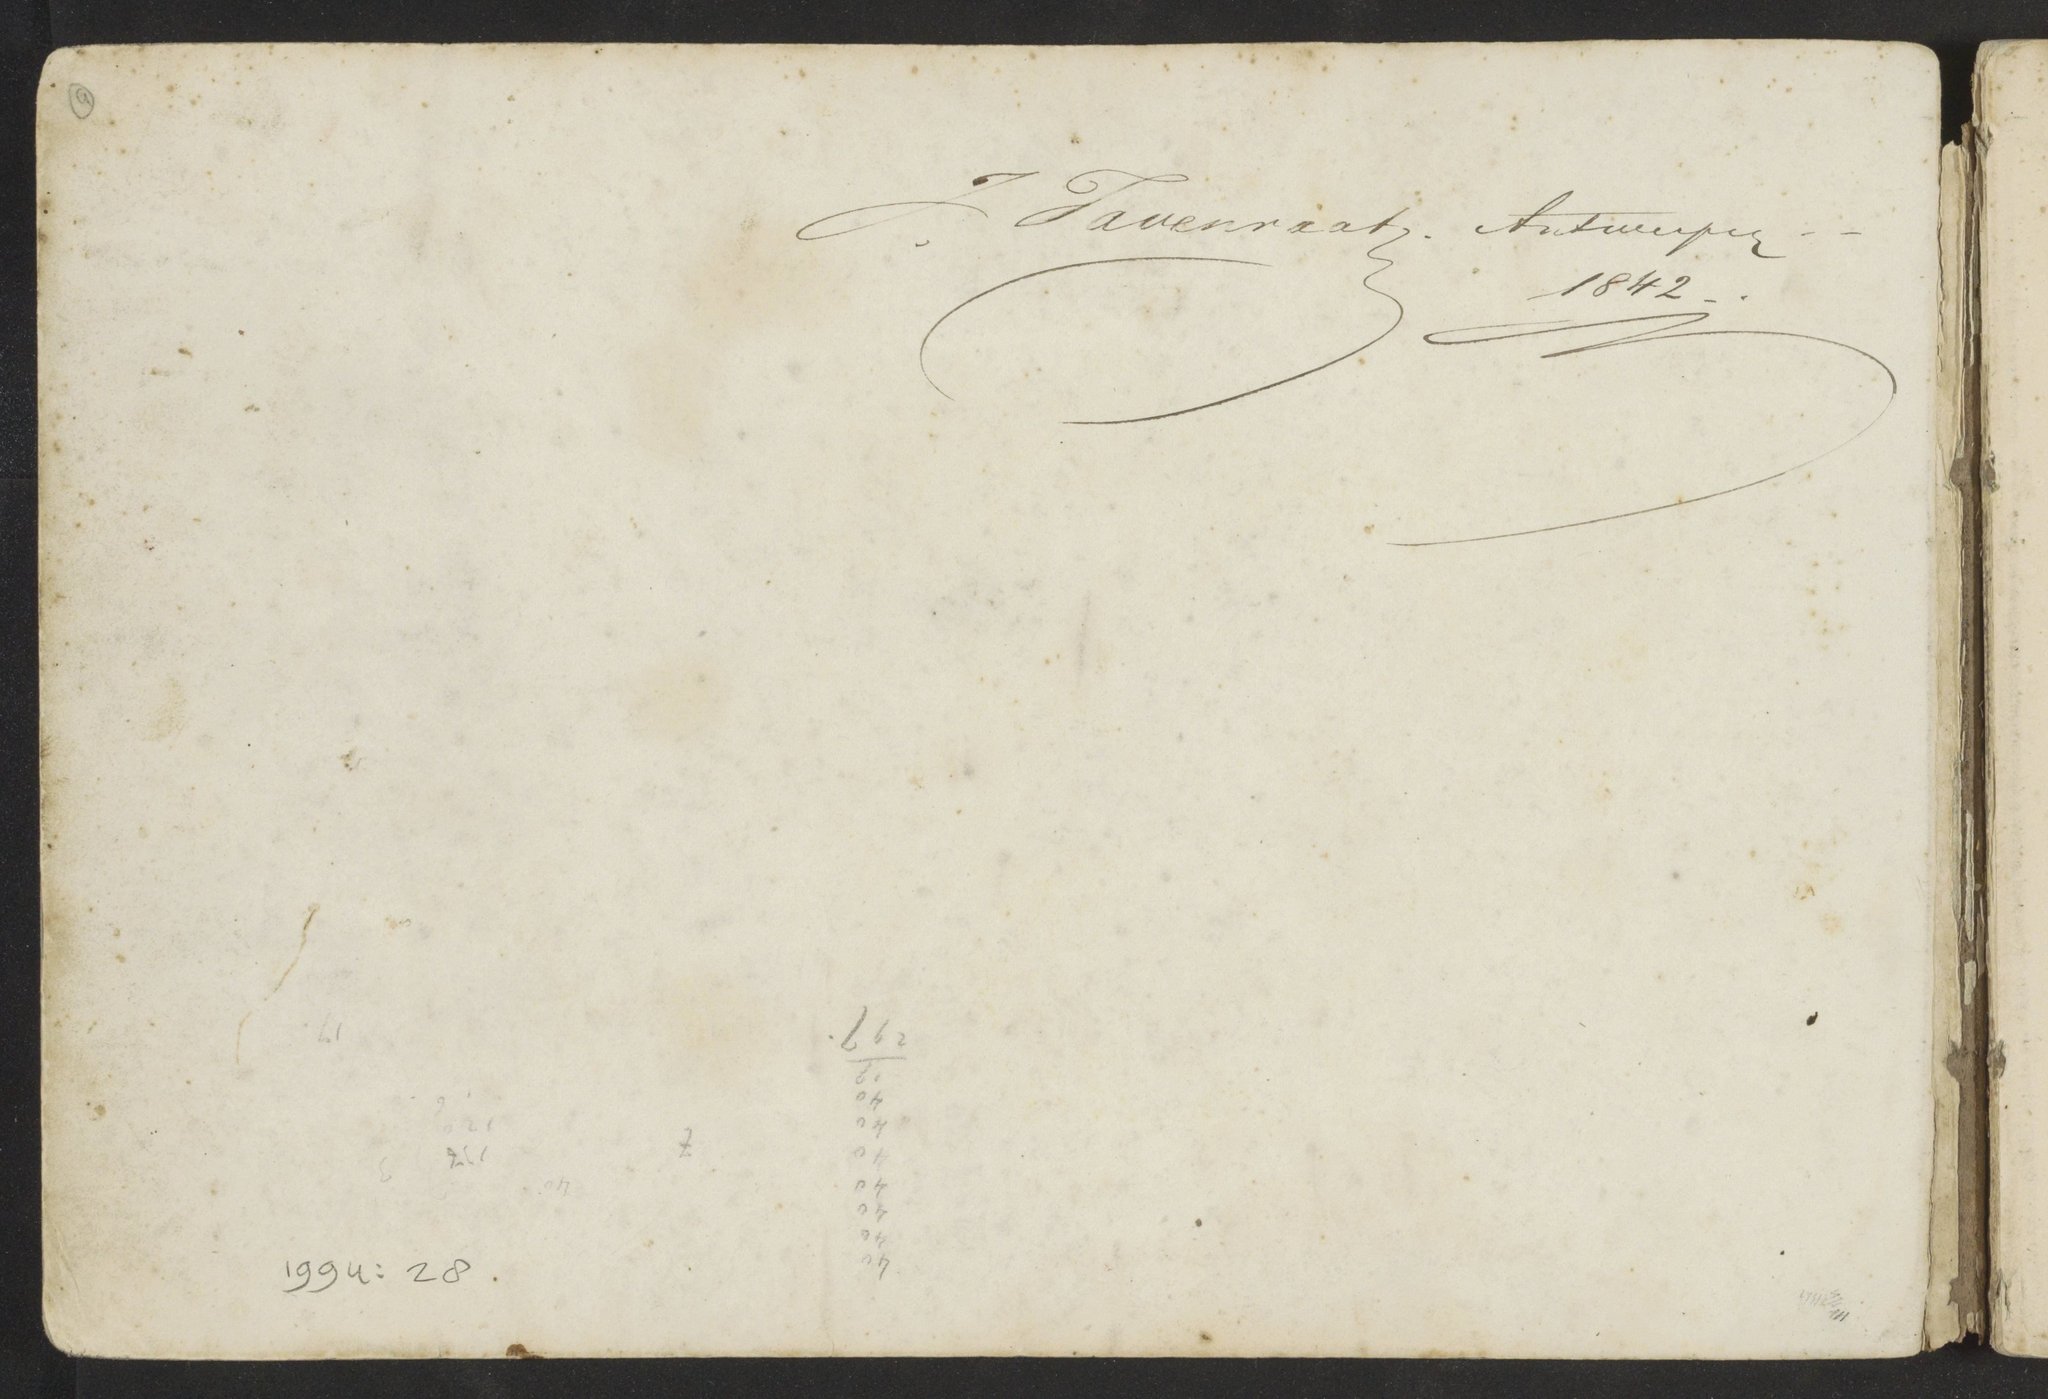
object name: endleaf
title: Berekeningen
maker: johannes tavenraat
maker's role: draughtsman, painter, print maker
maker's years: 1809-1881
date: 1842-1868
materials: ink, paper, pencil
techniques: pen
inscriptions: annotation: ‘[...]’, signature and date: ‘J. Tavenraat. Antwerpen / 1842.’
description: Voorste schutblad uit een schetsboek met 45 bladen.